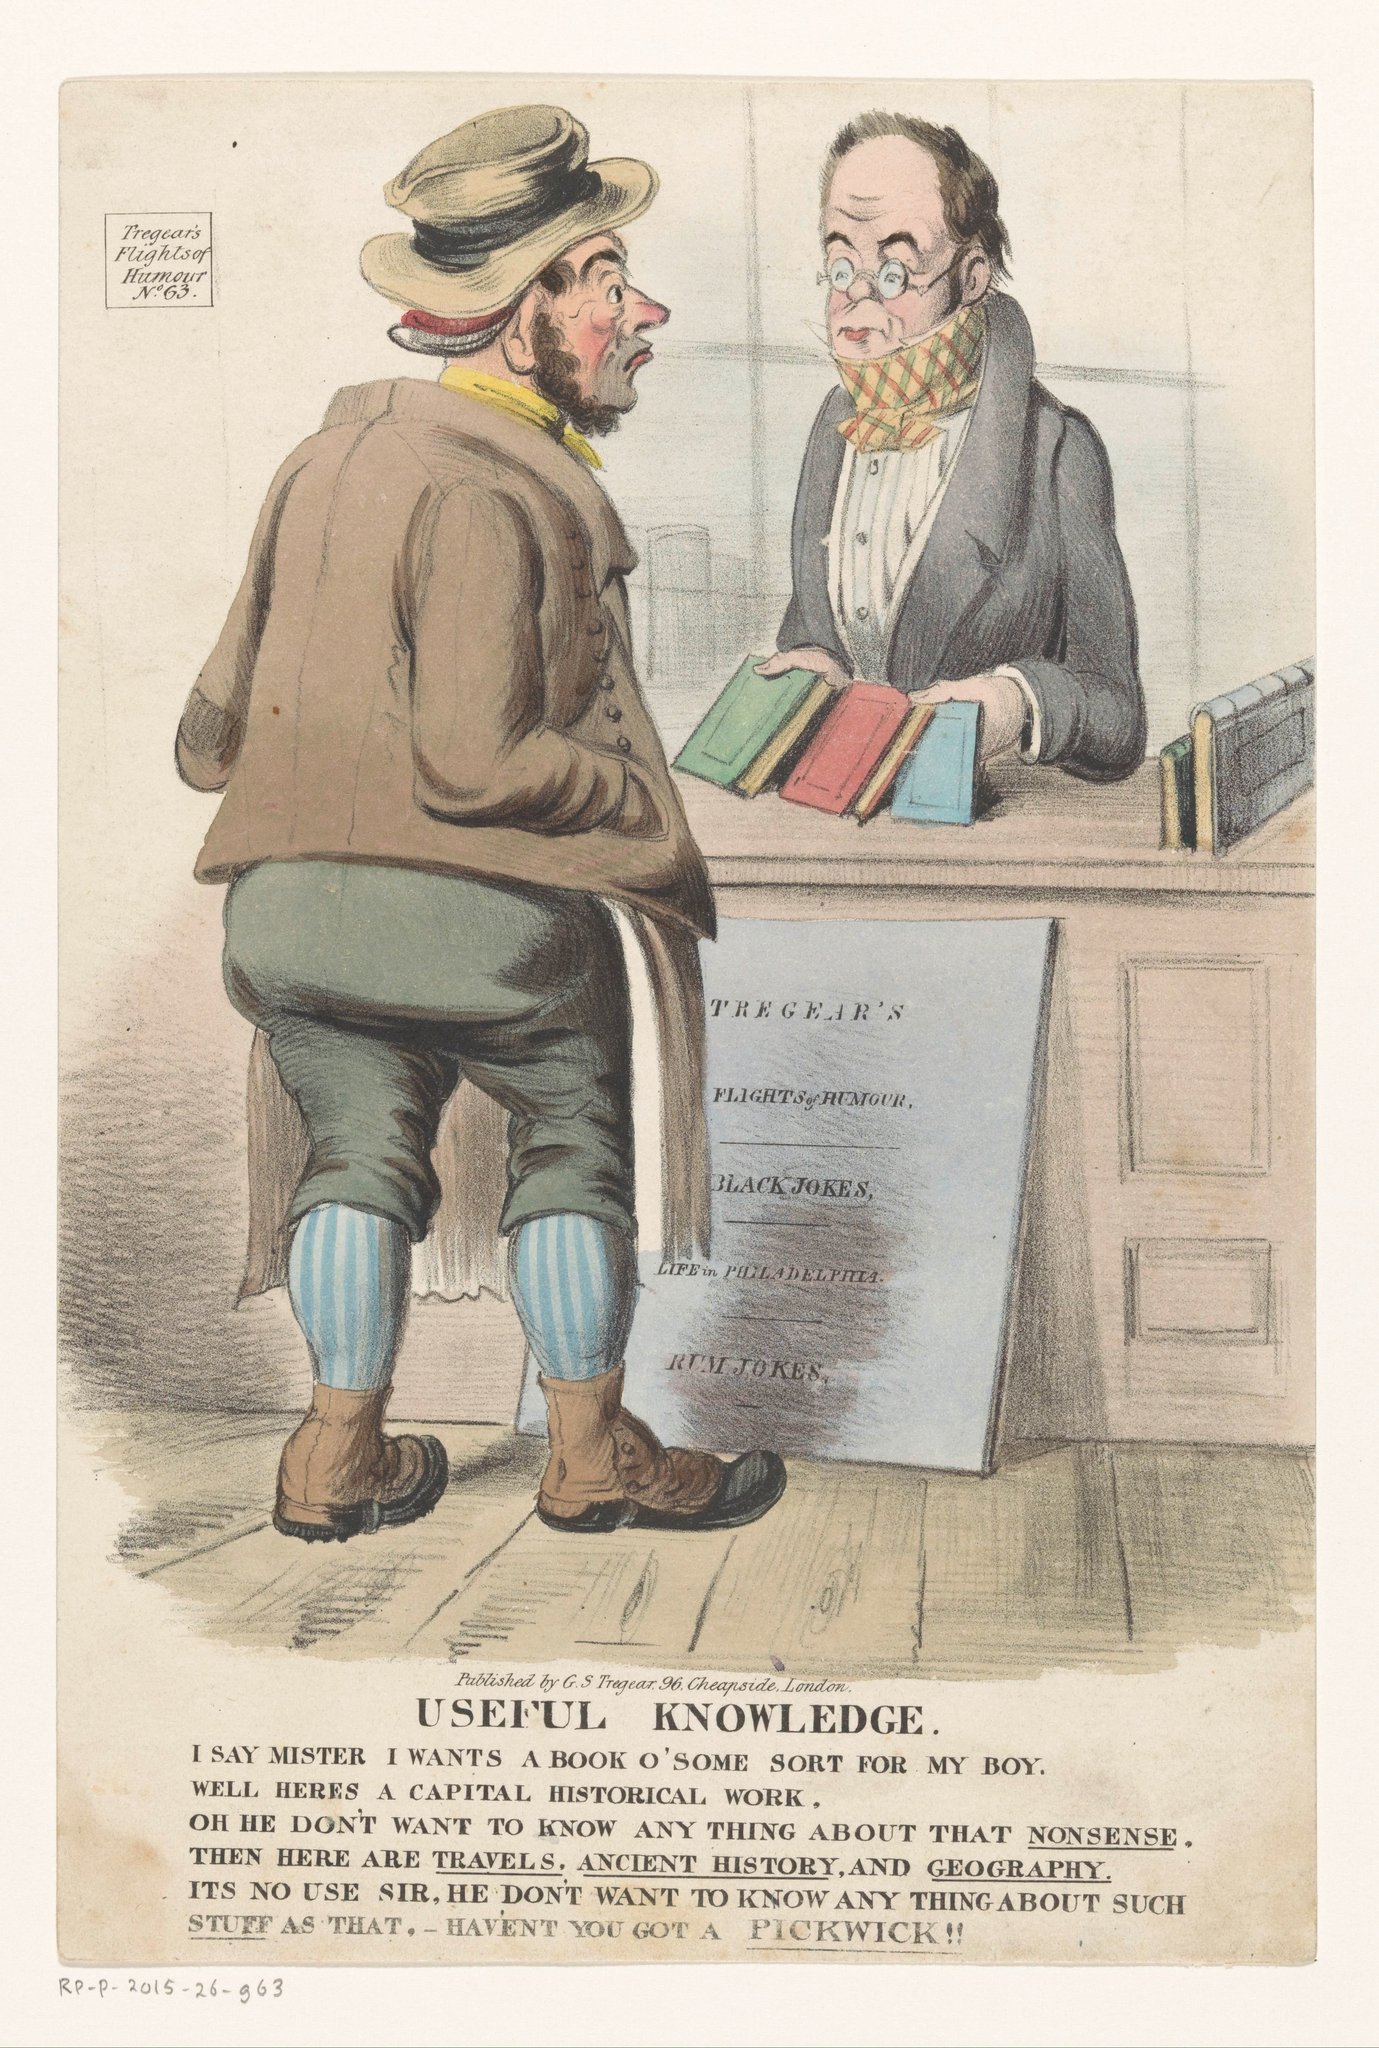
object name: print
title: Satirische voorstellingen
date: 1830-1840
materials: paper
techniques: hand coloring, lithograph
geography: london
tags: counter ~ shop, political caricatures and satires, book-shop, bookseller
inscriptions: collector's mark: Lugt 4780, collector's mark: Lugt 2228, collector's mark: Lugt 4779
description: Voor de toonbank staat een map met titels van prentseries die werden uitgeven door Tregear.